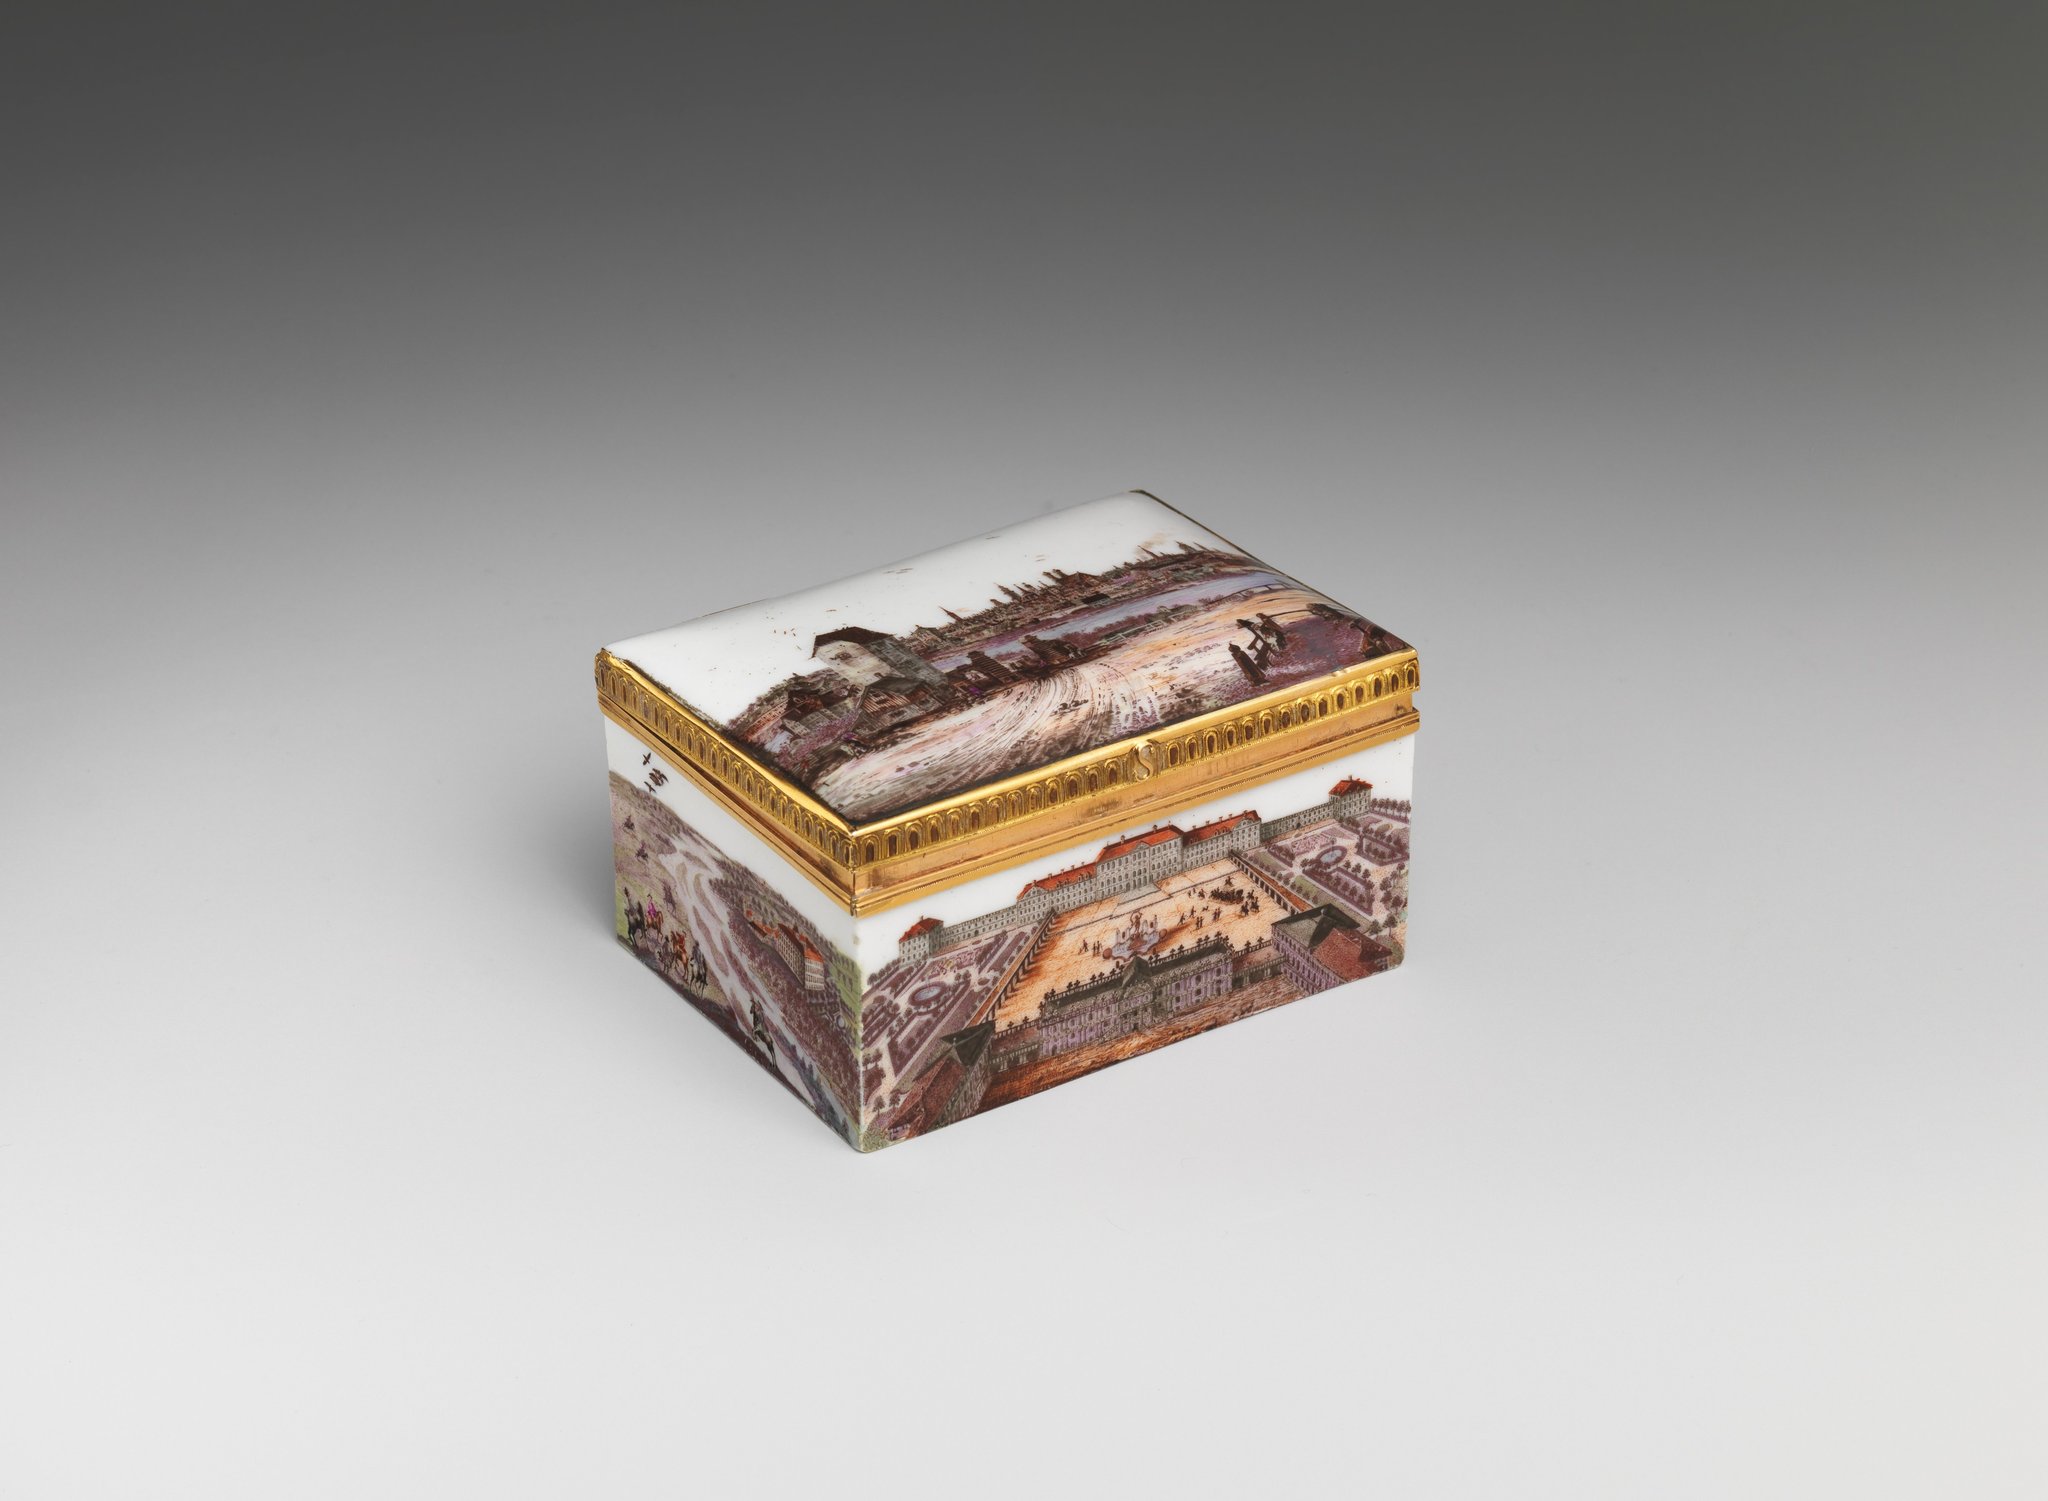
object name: snuffbox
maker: nymphenburg porcelain manufactory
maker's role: manufactory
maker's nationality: german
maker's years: 1747-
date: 1770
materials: gold, hard paste porcelain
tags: castles